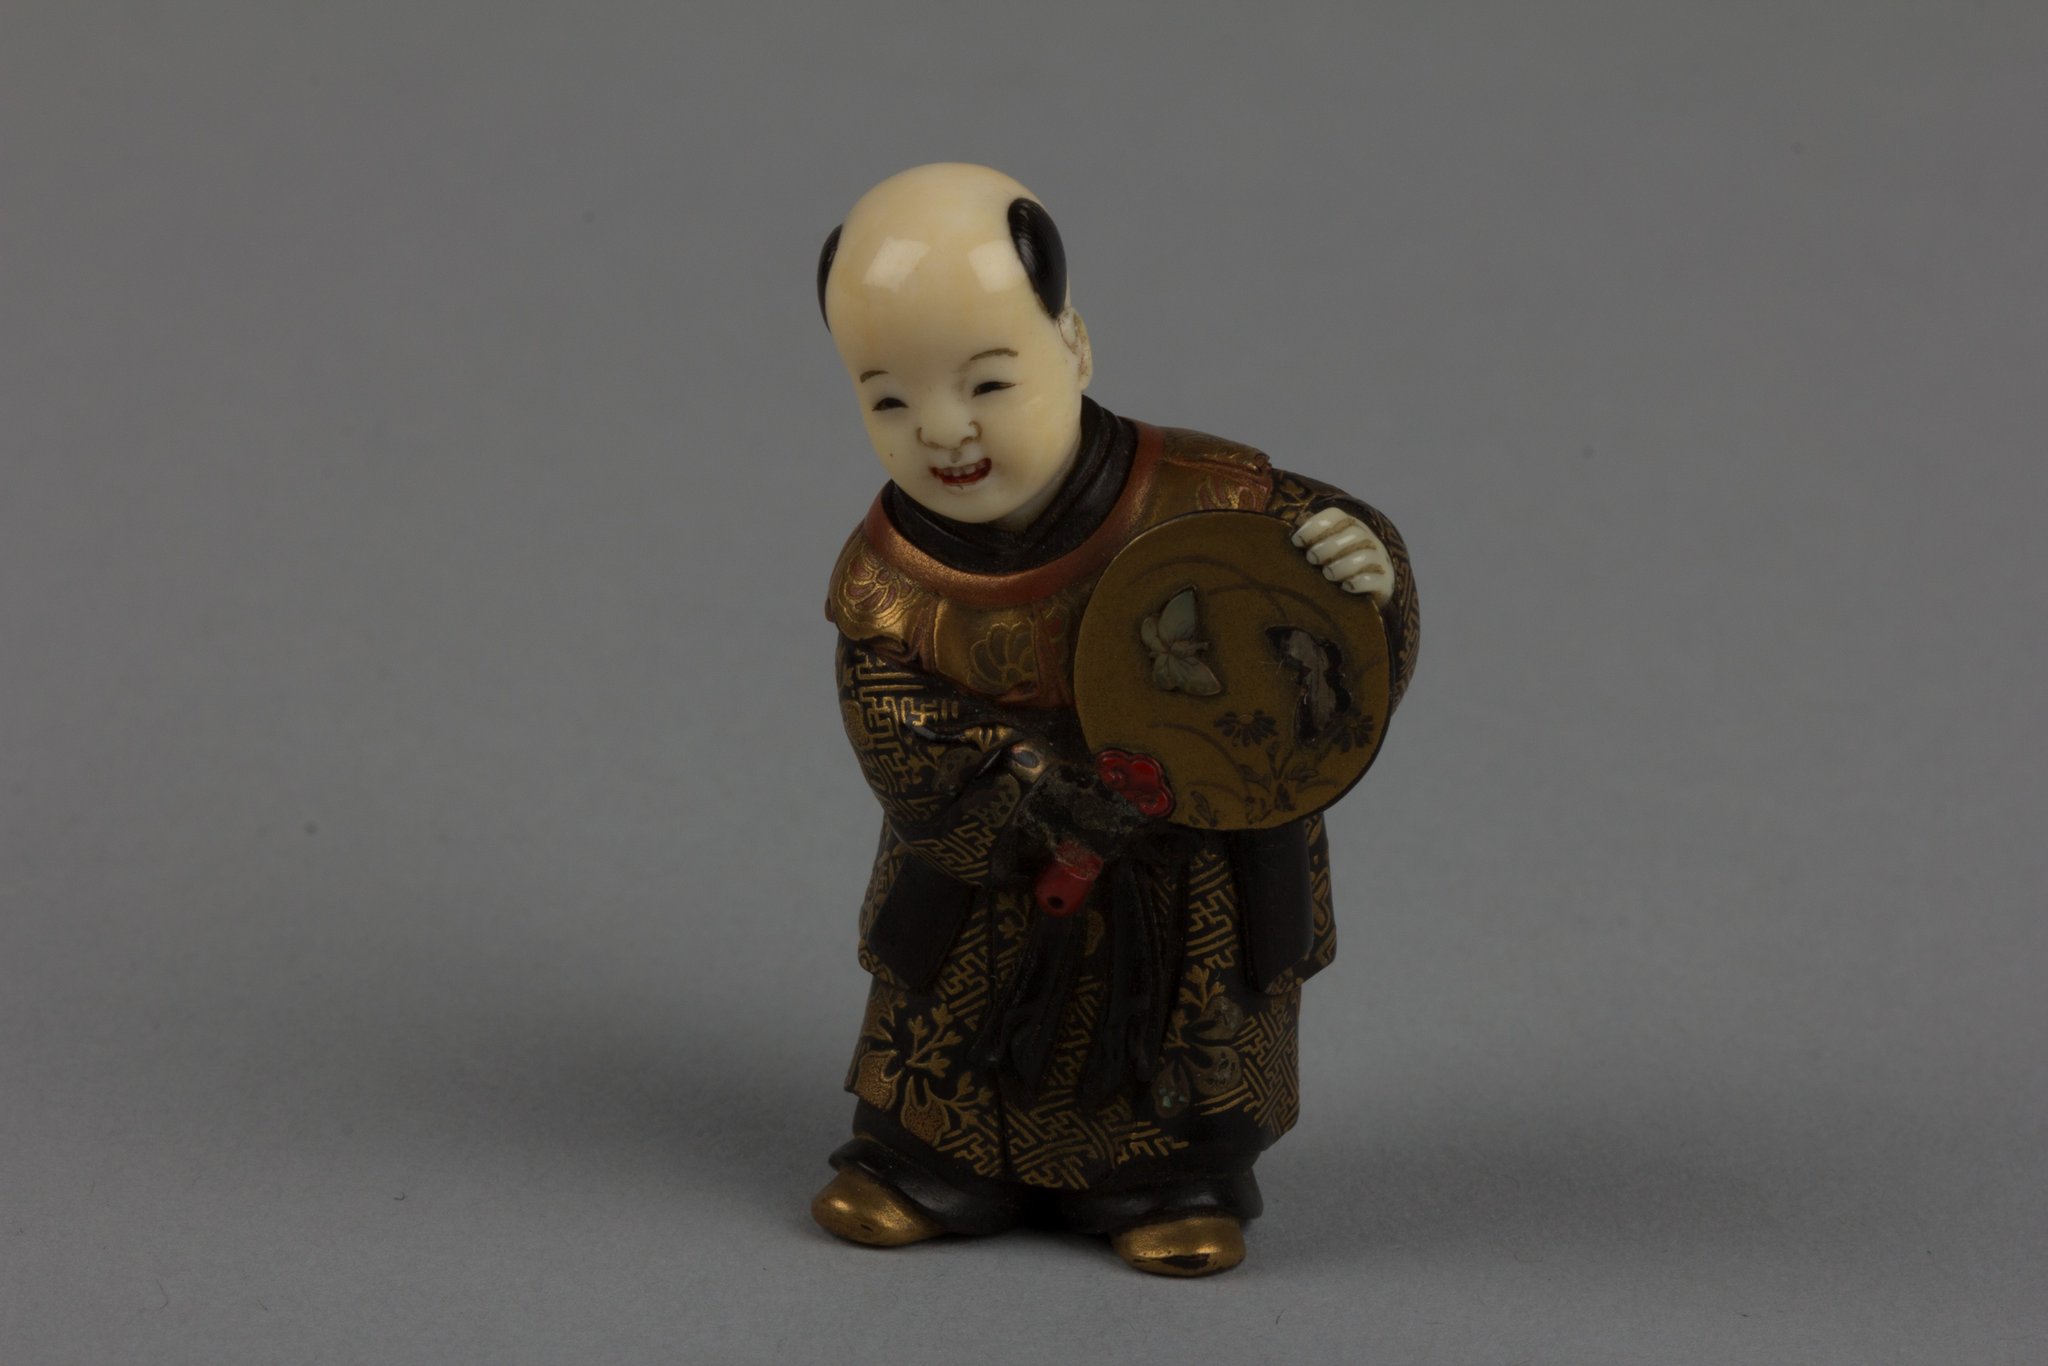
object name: netsuke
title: Netsuke of Boy with a Fan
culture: japanese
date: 1801-1900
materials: ivory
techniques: lacquer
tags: fans,boys